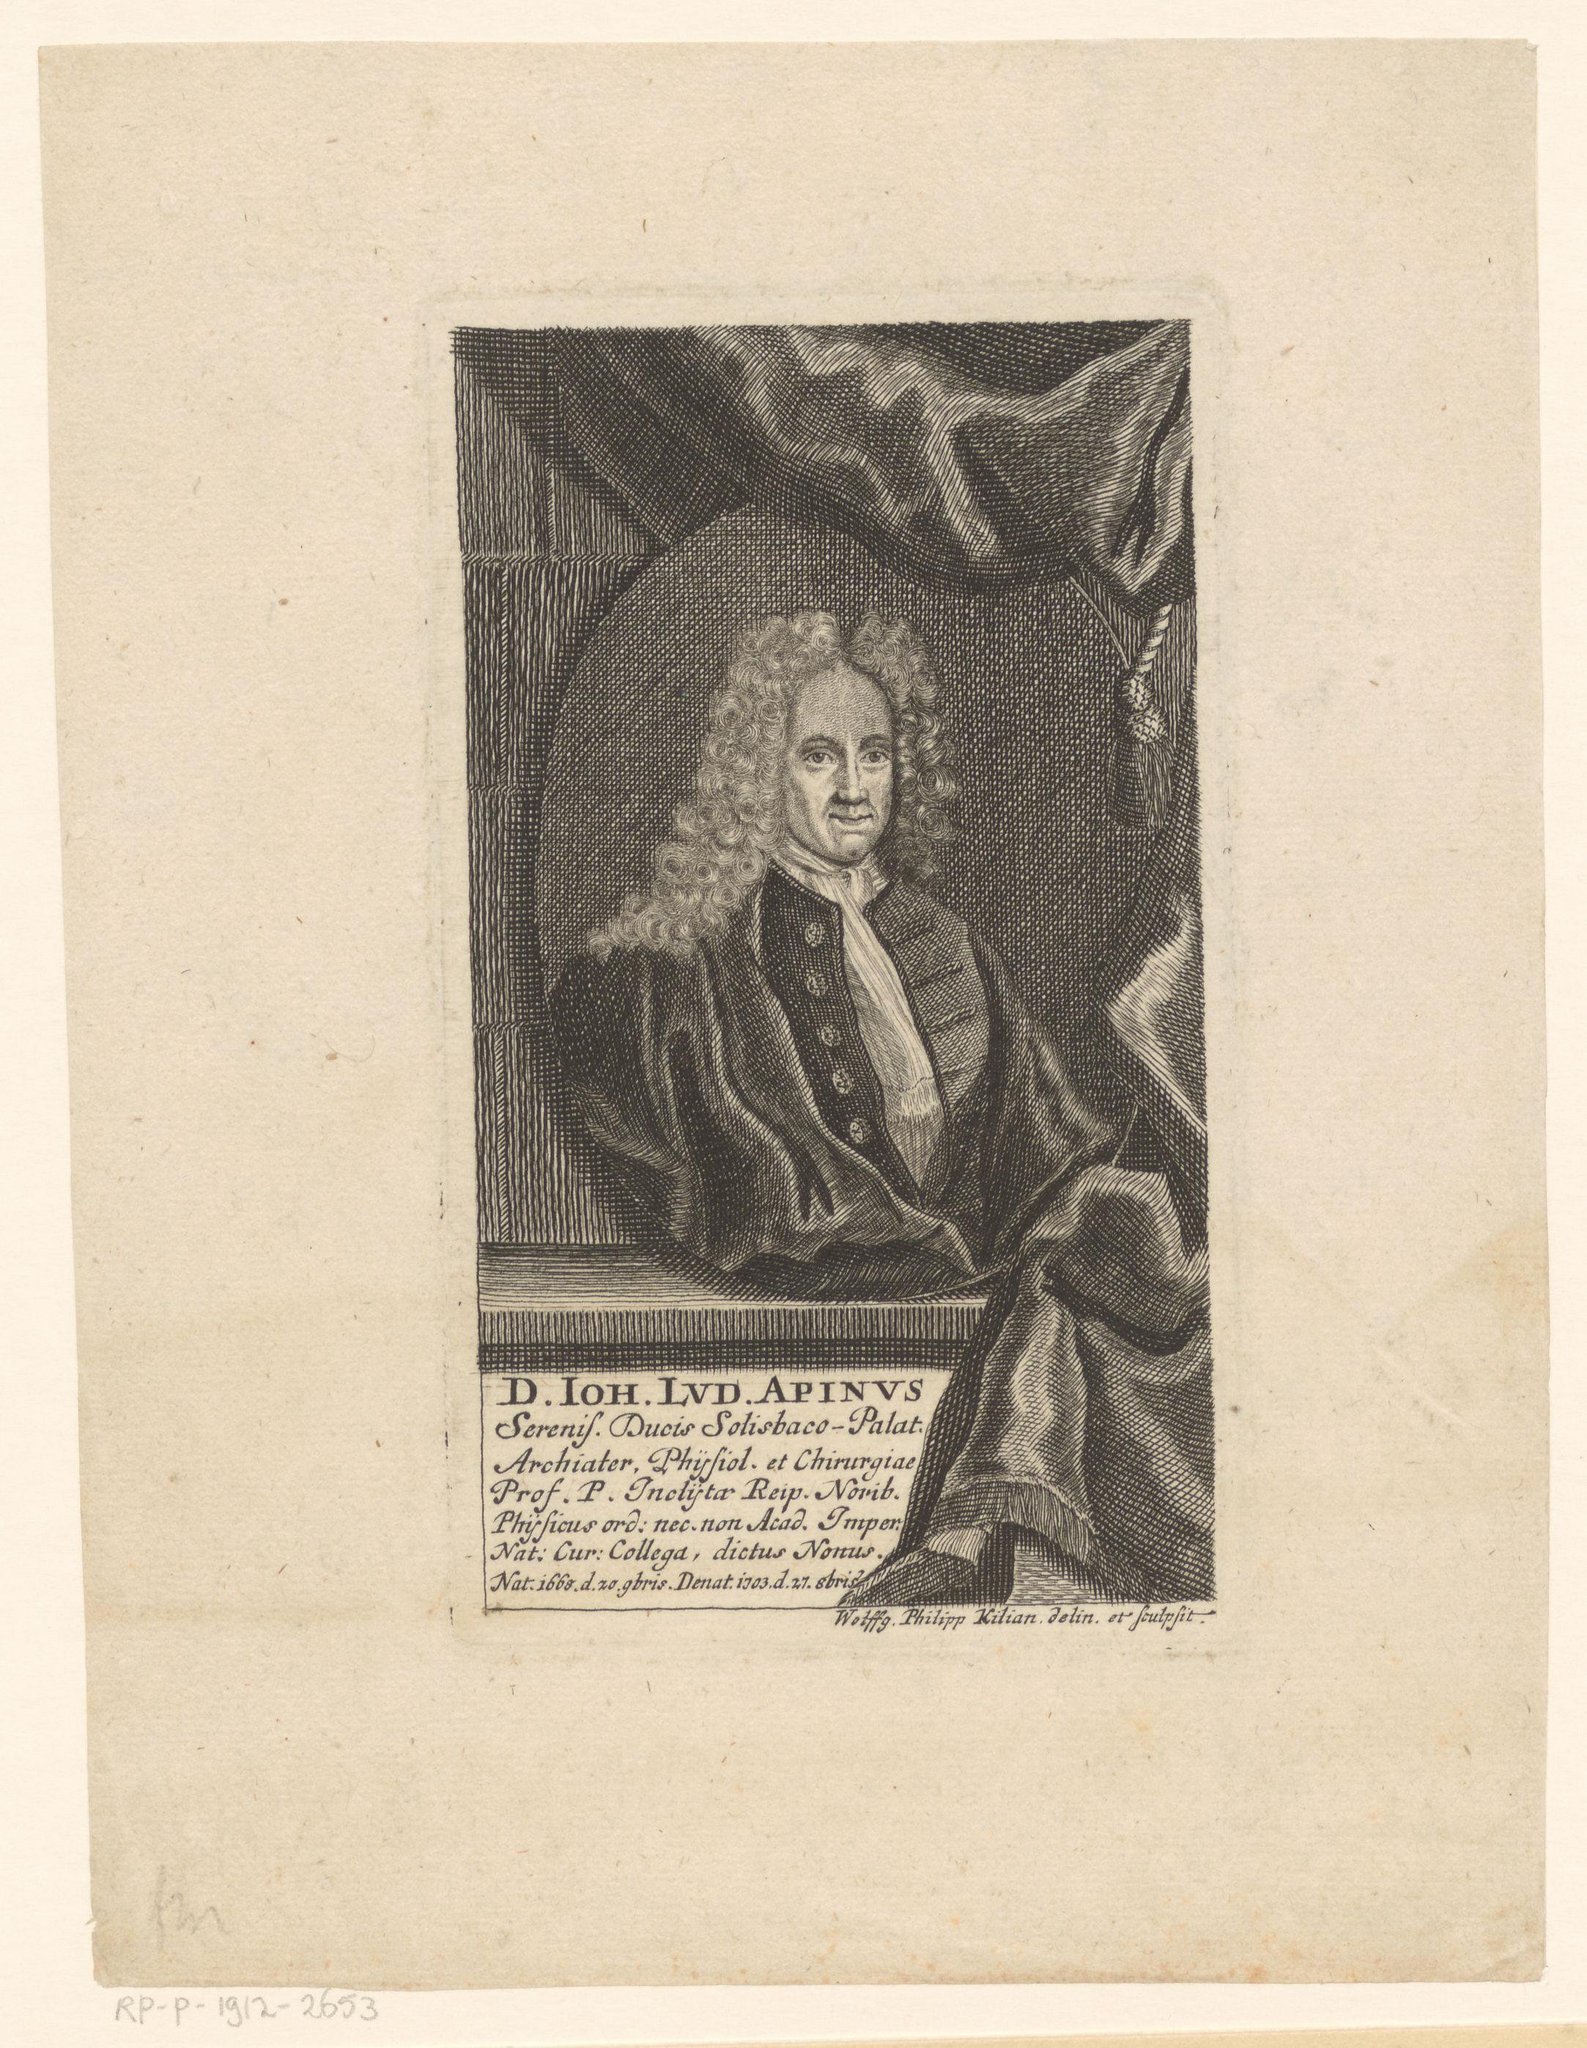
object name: print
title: Portret van Johann Ludwig Apin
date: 1703-1732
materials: paper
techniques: engraving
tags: historical persons, physician, doctor (+ portrait of scholar, scientist)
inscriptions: collector's mark: Lugt 2228